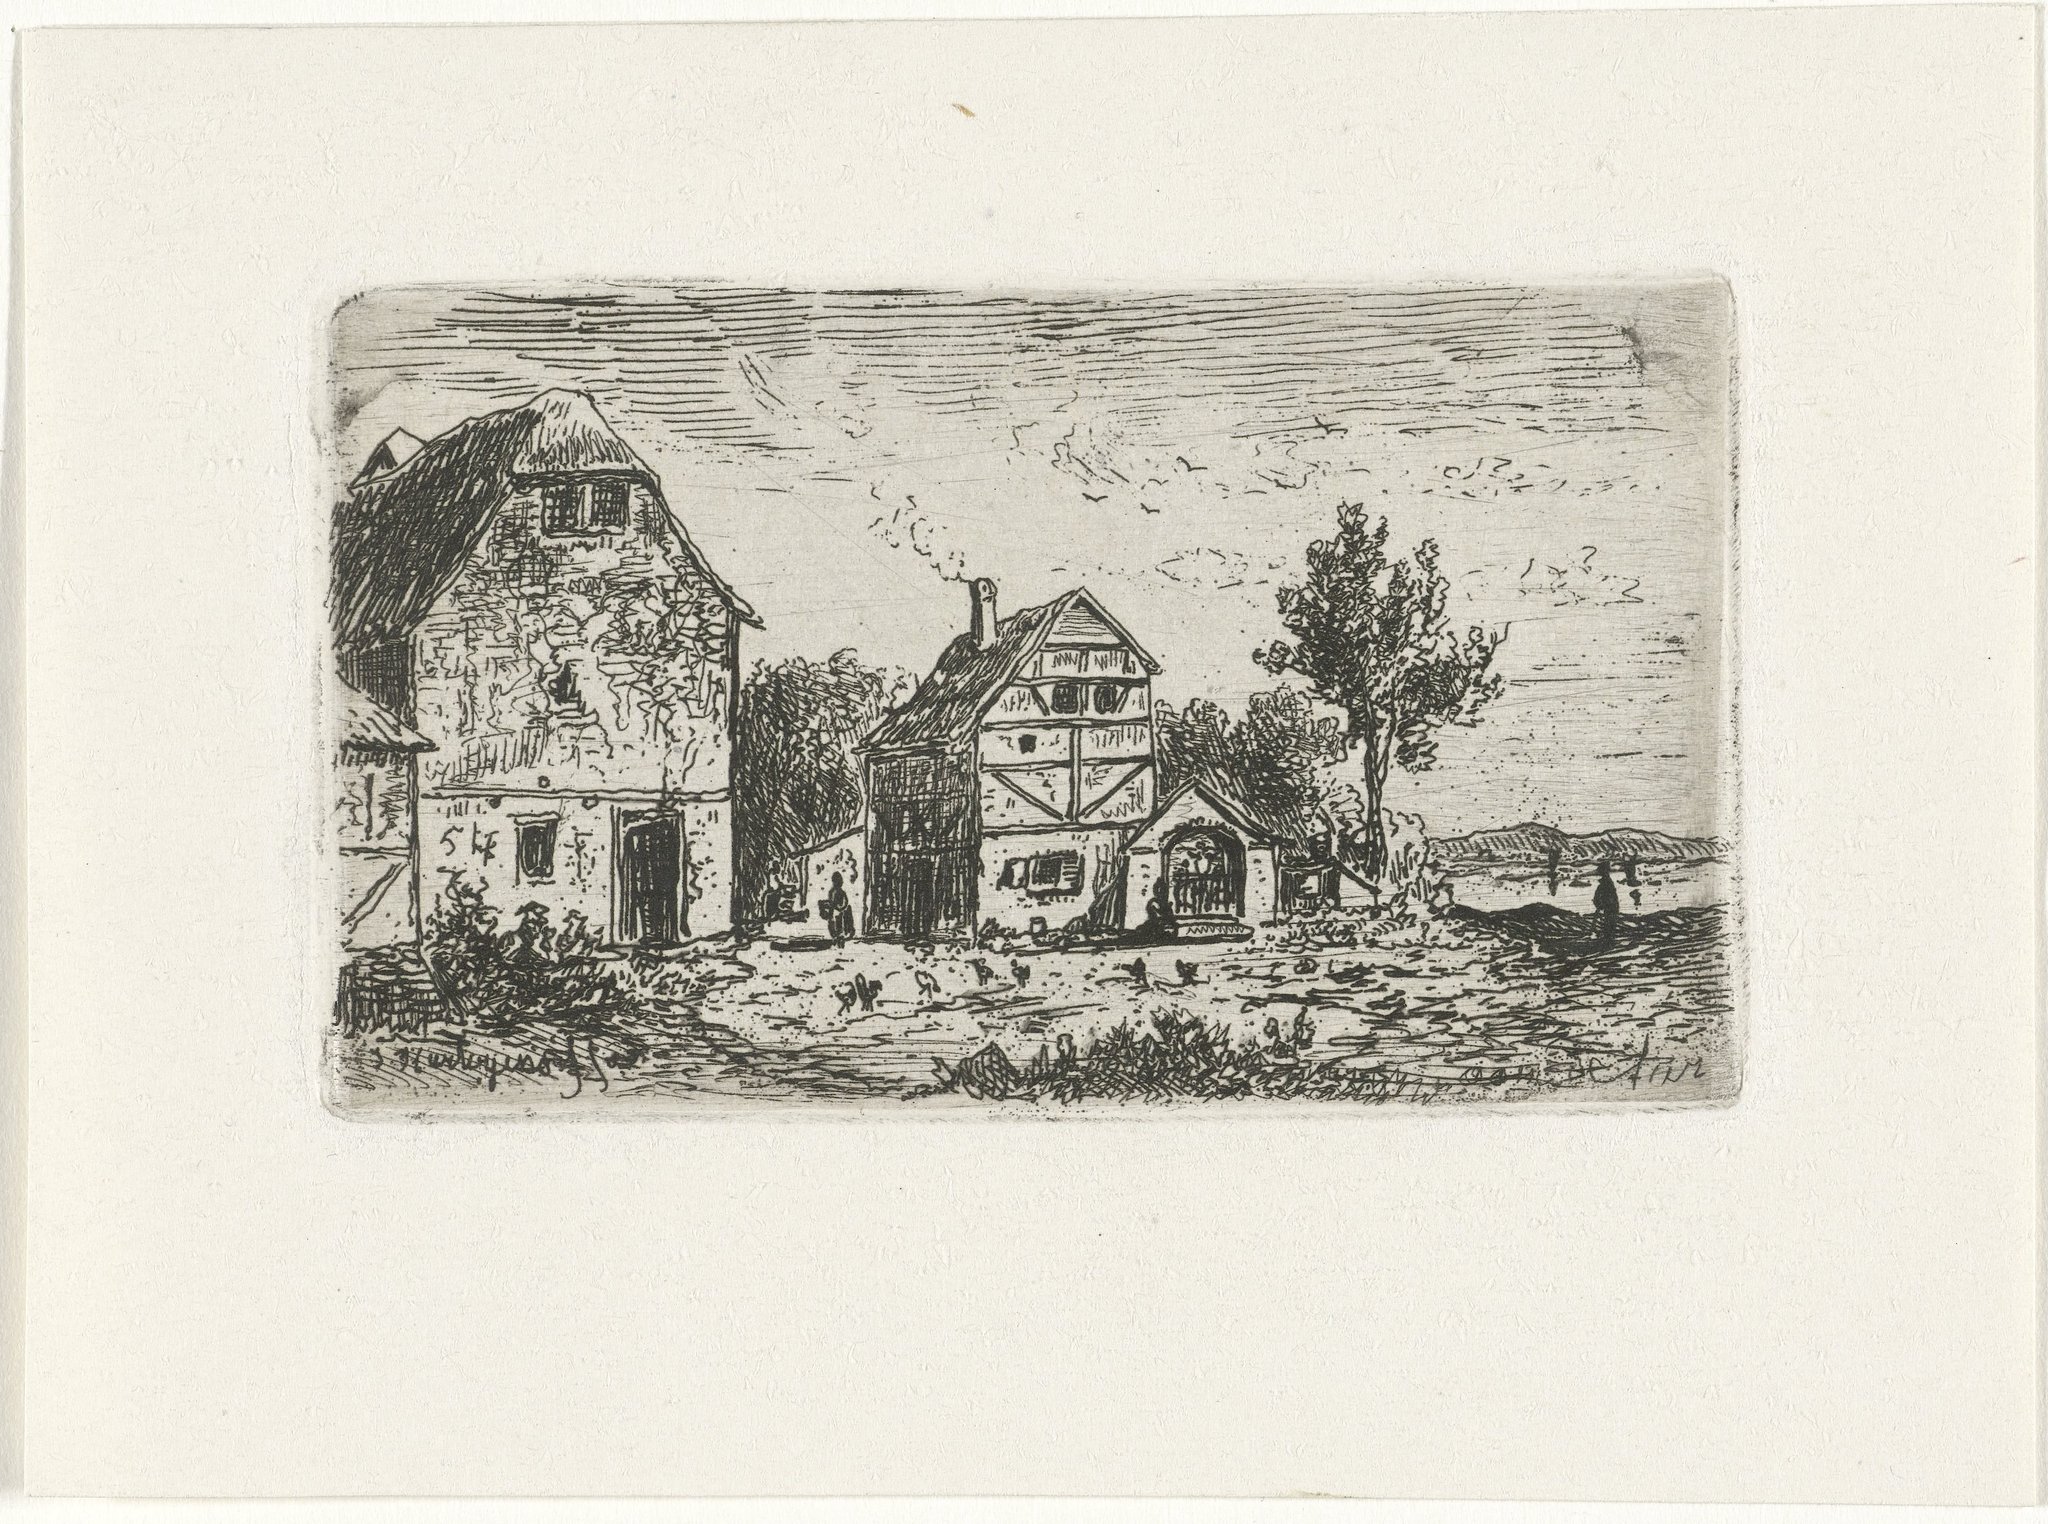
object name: print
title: Gebouwen aan de Aar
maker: joseph hartogensis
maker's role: painter, print maker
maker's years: 1822-1865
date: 1837-1865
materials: paper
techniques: etching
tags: rural housing, e.g. country-house, villa, cottage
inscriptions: collector's mark: Lugt 2228